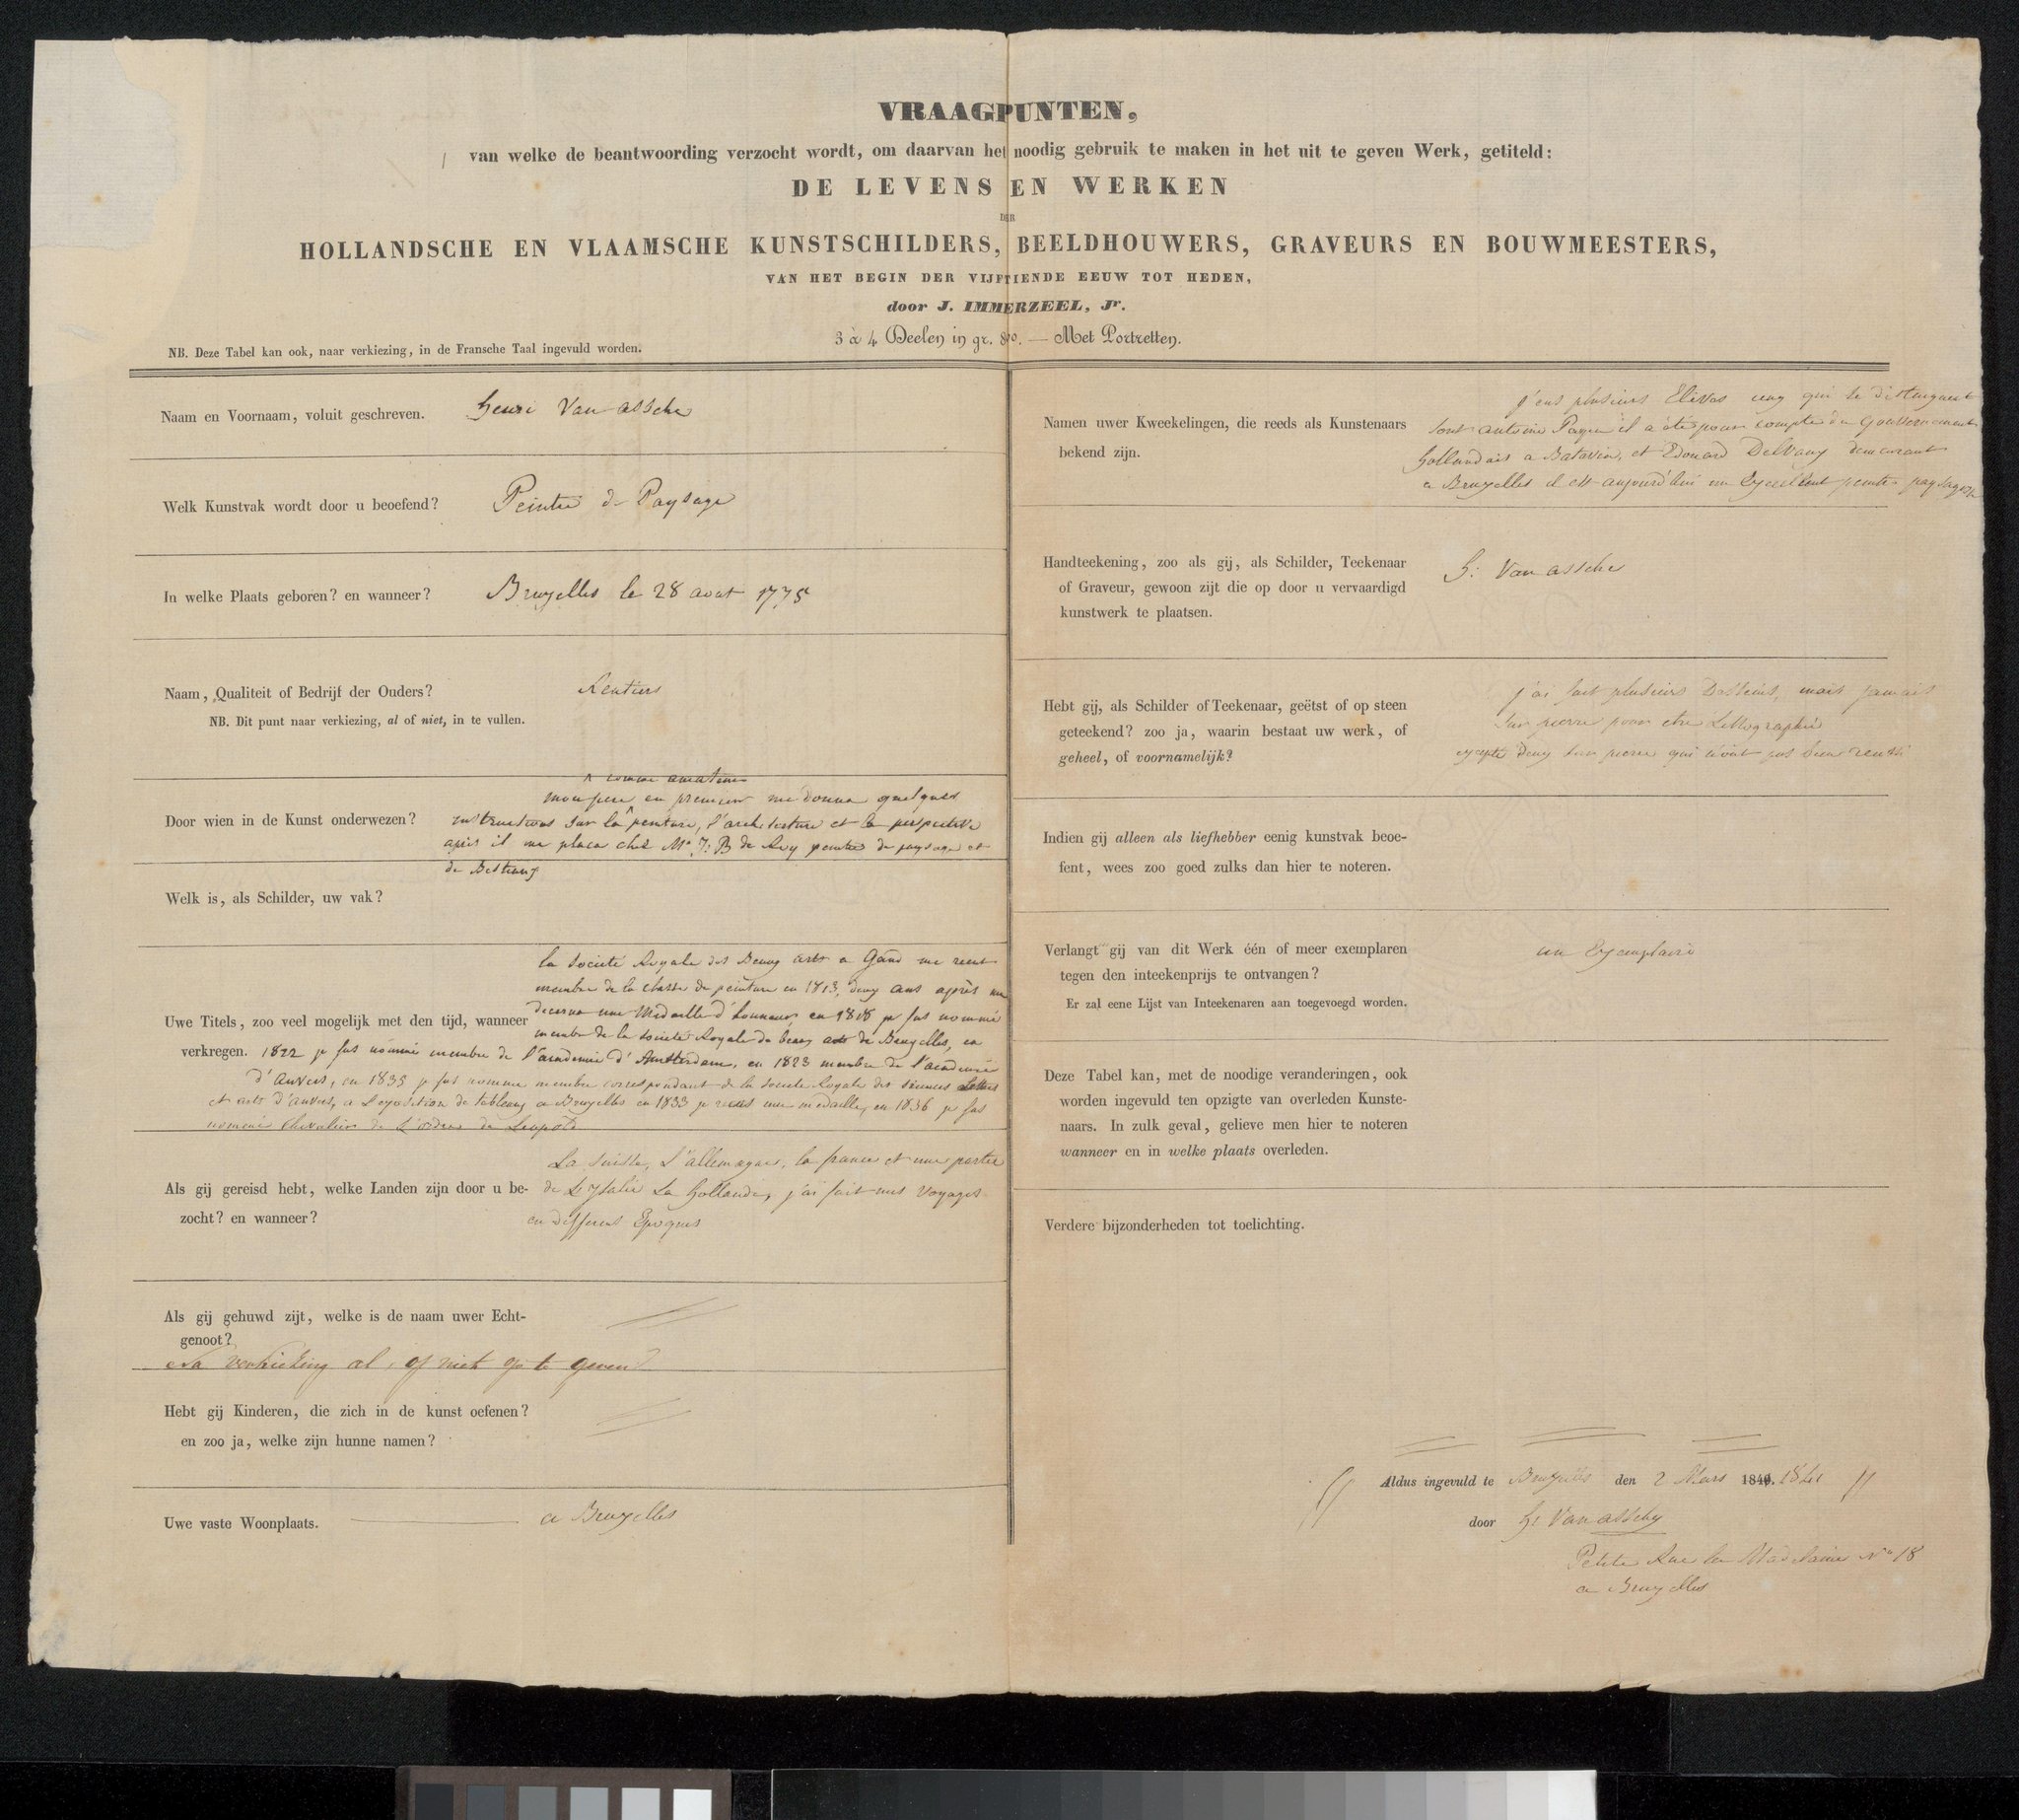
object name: manuscript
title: Enquêteformulier ingevuld door Henri van Assche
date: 1841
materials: ink, paper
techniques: pen, printing, writing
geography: brussels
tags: henri van assche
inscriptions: inscription: ‘Vraagpunten,/ van welke de beantwoording verzocht wordt, om daarvan het noodig gebruik te maken in het uit te geven Werk, getiteld: De levens en werken/ der Hollandsche en Vlaamsche kunstschilders, beeldhouwers,/ graveurs en bouwmeesters, van het begin der vijftiende eeuw tot heden/ door J. Immerzeel, Jr.’, watermark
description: Opgenomen in: Immerzeel, J. Jr., De levens en werken der Hollandsche en Vlaamsche kunstschilders, beeldhouwers, graveurs en bouwmeesters, van het begin der vijftiende eeuw tot heden, Amsterdam: J.C. van Kesteren, 1842-1843.